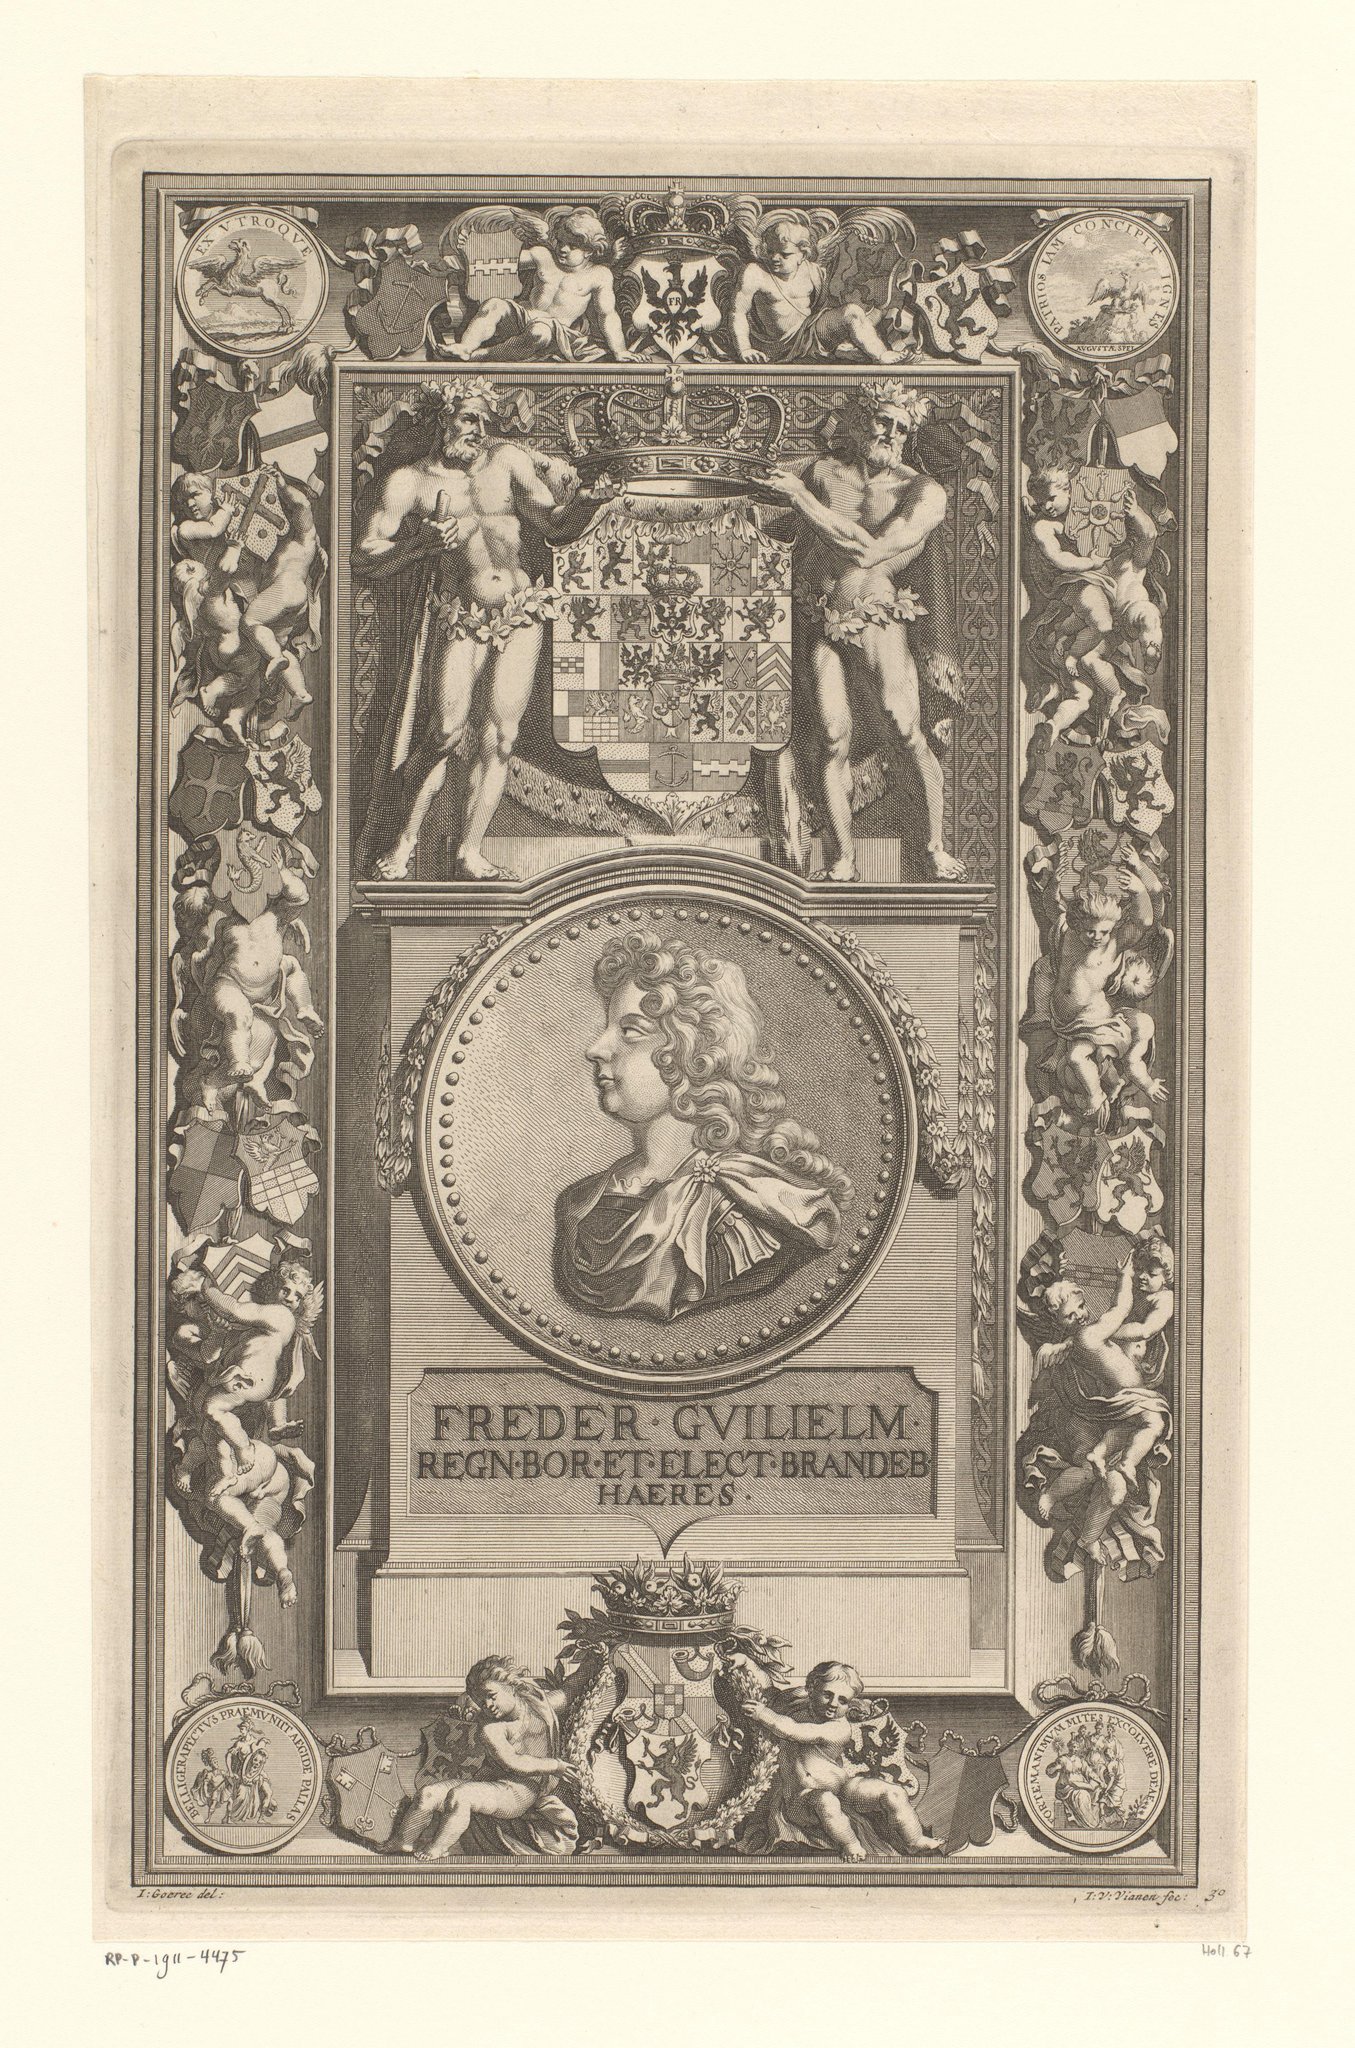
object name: print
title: Portret van Frederik Willem, keurvorst van Brandenburg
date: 1670-1726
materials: paper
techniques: etching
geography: northern netherlands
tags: berlin, frederik willem van brandenburg (i), cupids: 'amores', 'amoretti', 'putti'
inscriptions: collector's mark: Lugt 2228